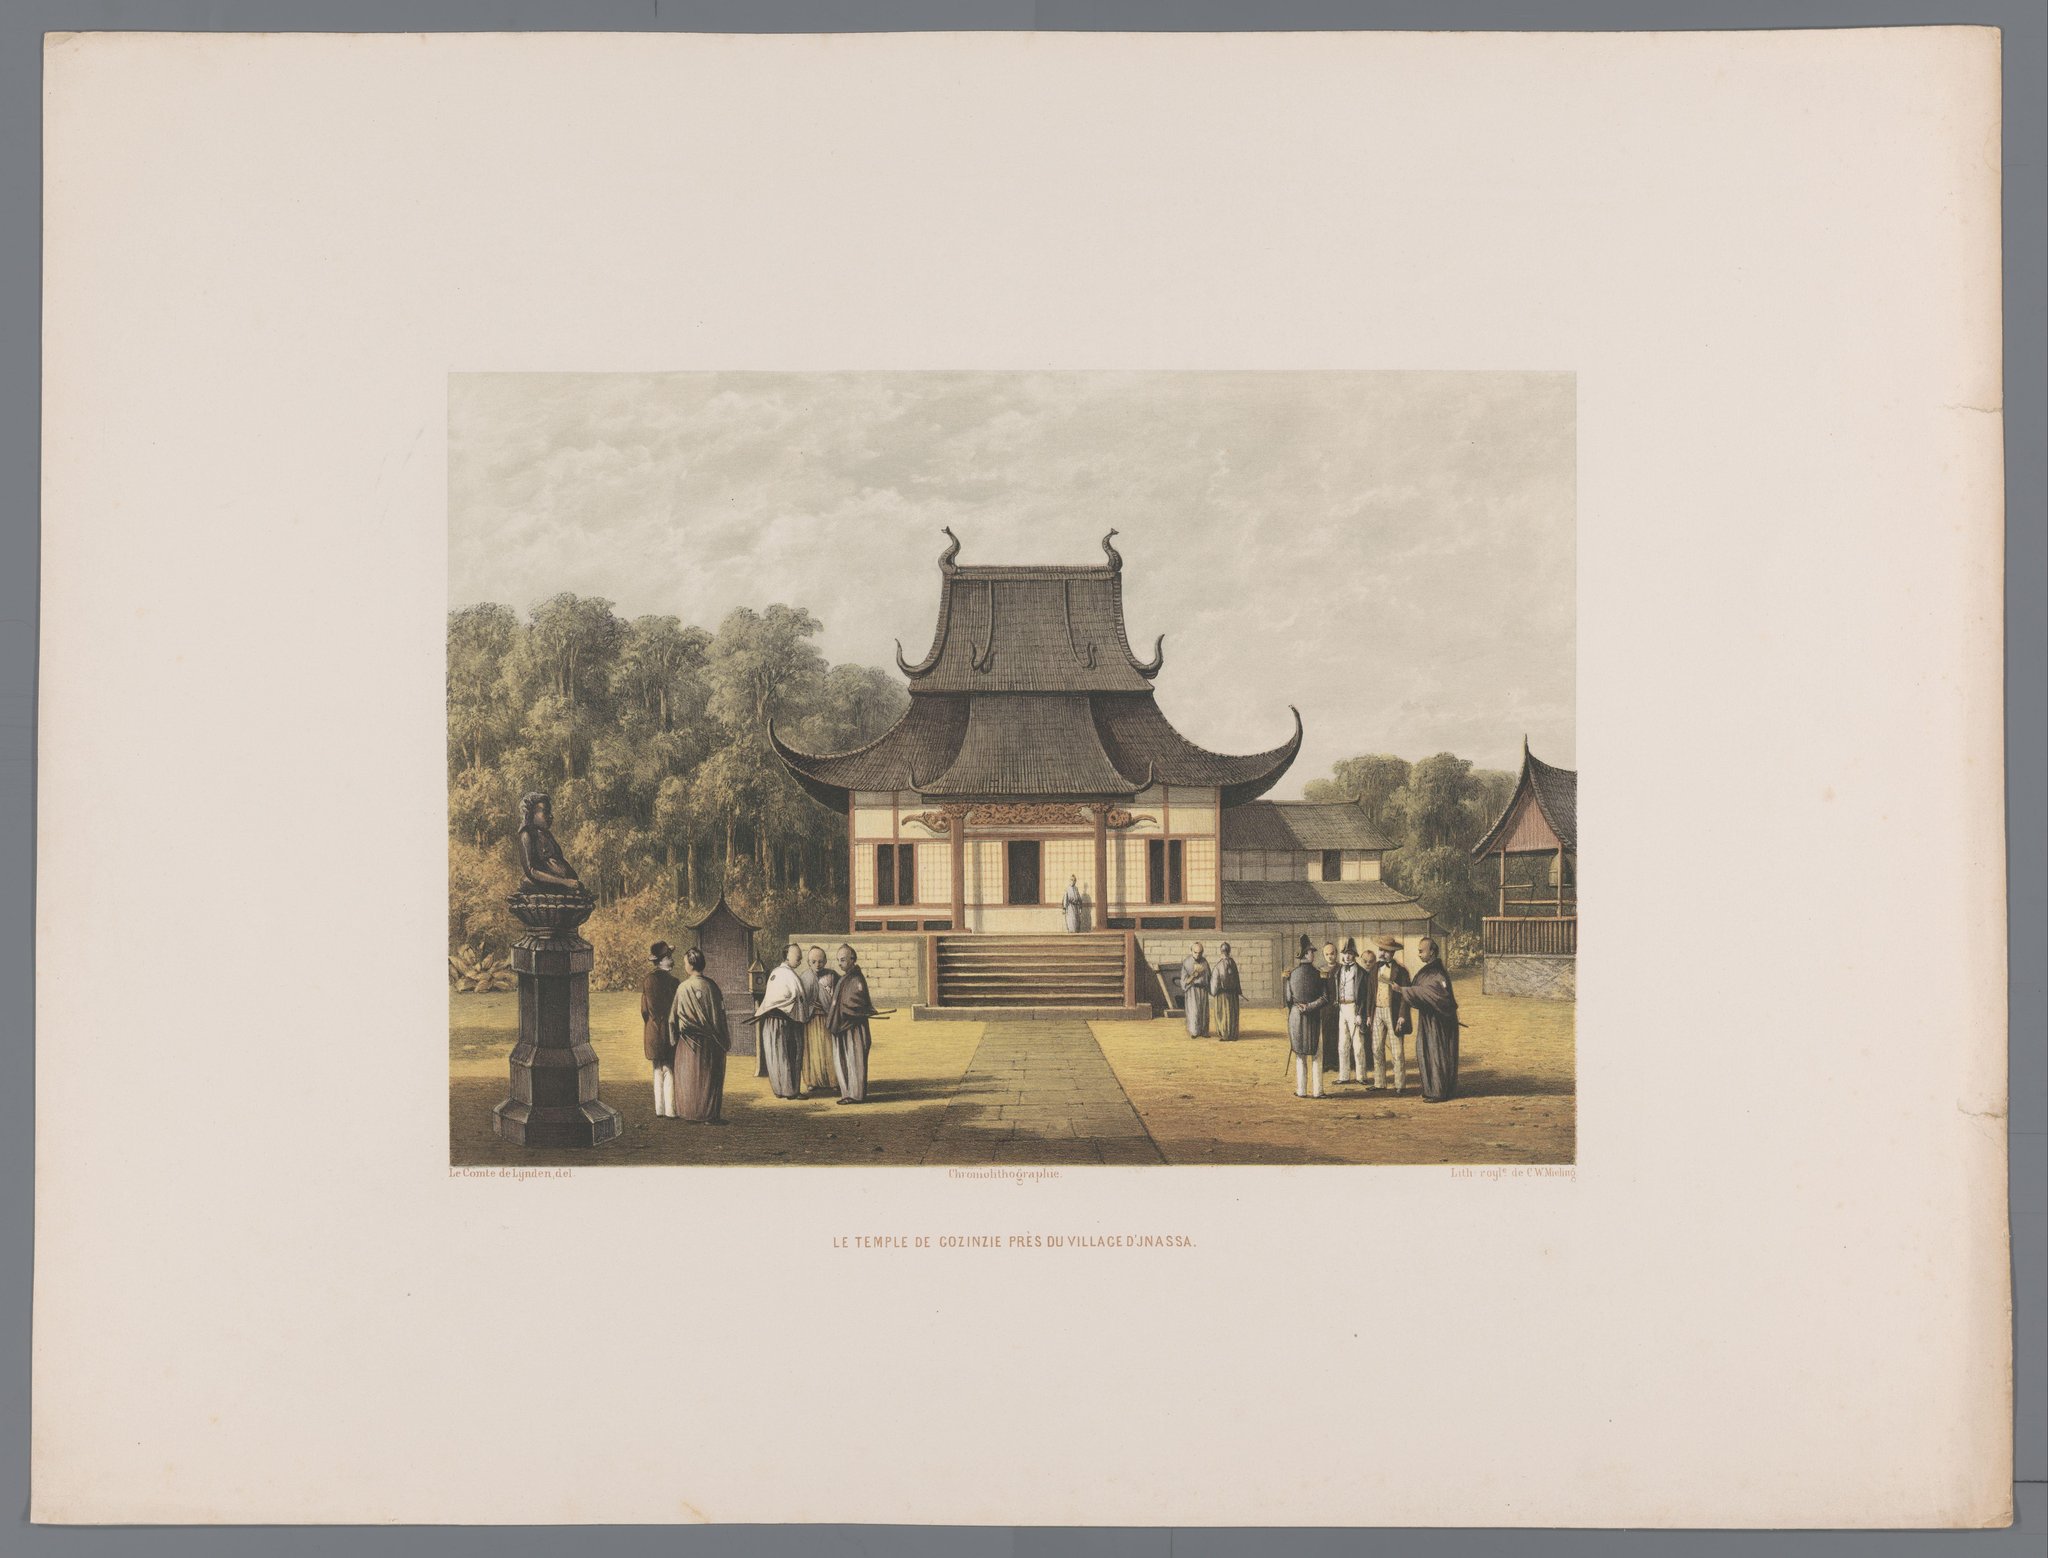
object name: print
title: Souvenir du Japon vues d'après nature avec texte par le comte de Lijnden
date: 1862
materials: paper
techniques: chromolithography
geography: the hague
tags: temple, shrine ~ non-christian religions, japan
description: Gezicht op de Gozinzie tempel bij D'jnassa. Op de voorgrond staan Japanners en Hollanders.